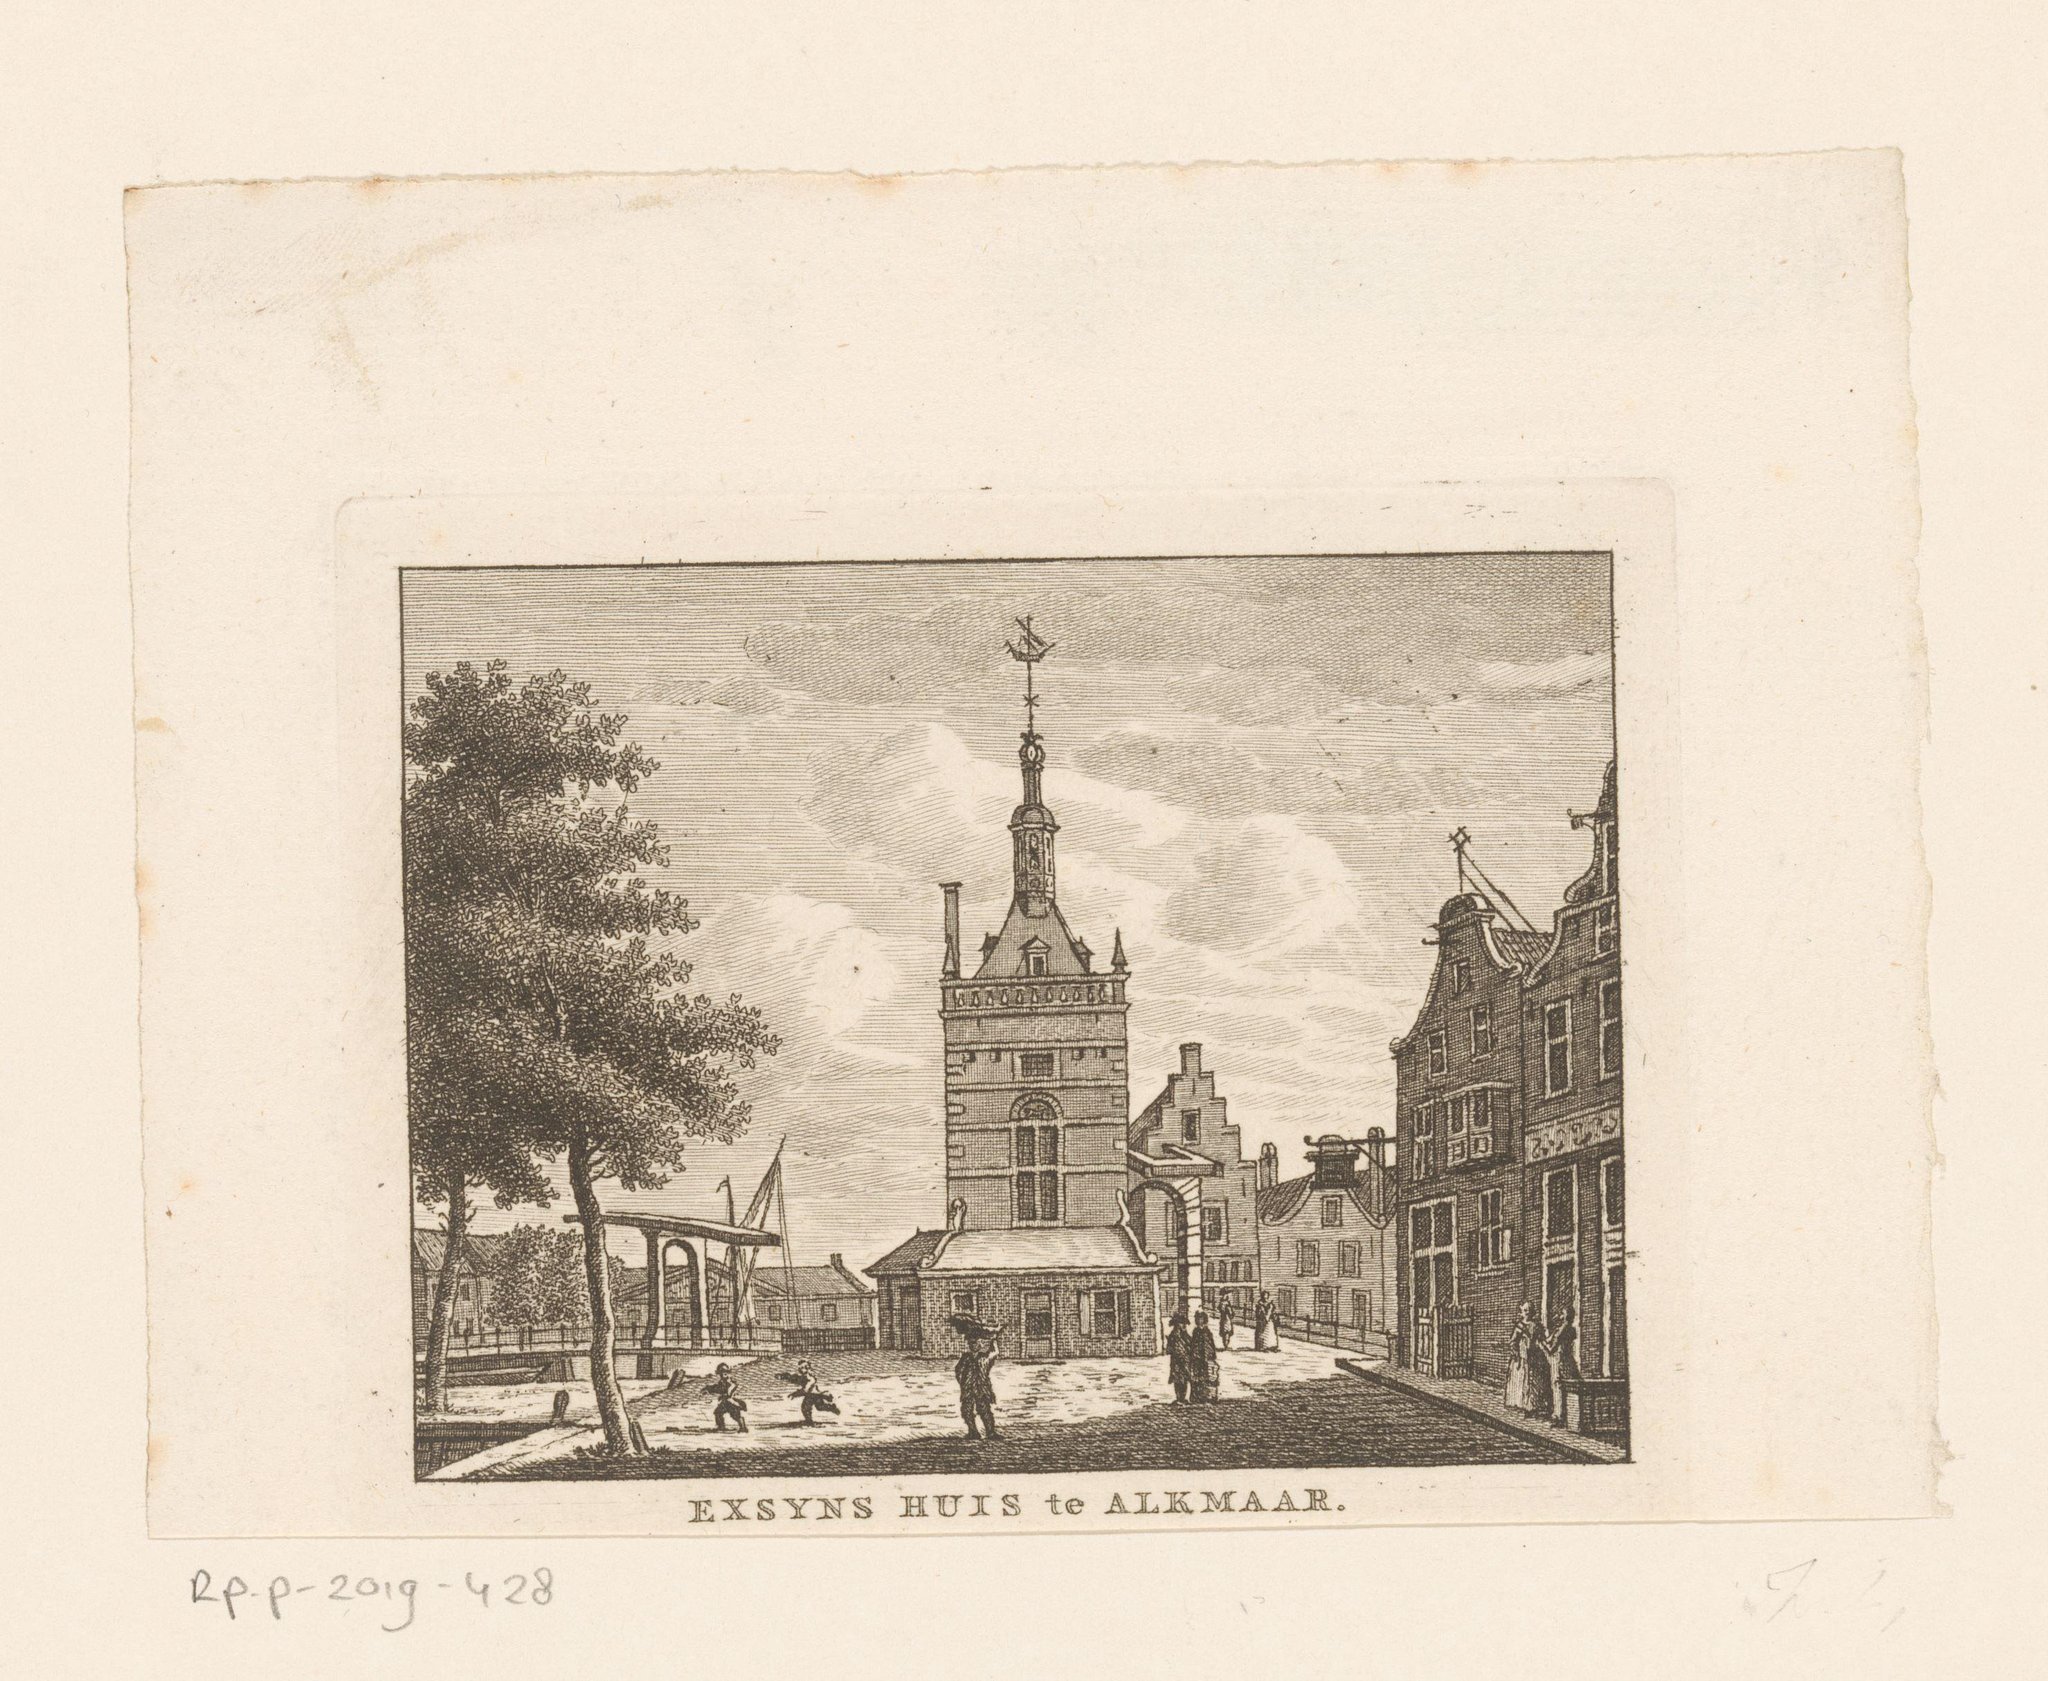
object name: print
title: Excyns huis te Alkmaar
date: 1736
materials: paper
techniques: etching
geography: amsterdam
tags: civic architecture; edifices; dwellings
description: Prent verschenen in: Alle de voornaamste gezichten van de wijdberoemde steden Alkmaar, Delft en Dordrecht. Amsterdam: Leonardus Schenk, 1736. Prent is het bovenste deel van een plaat met twee gezichten op Alkmaar.